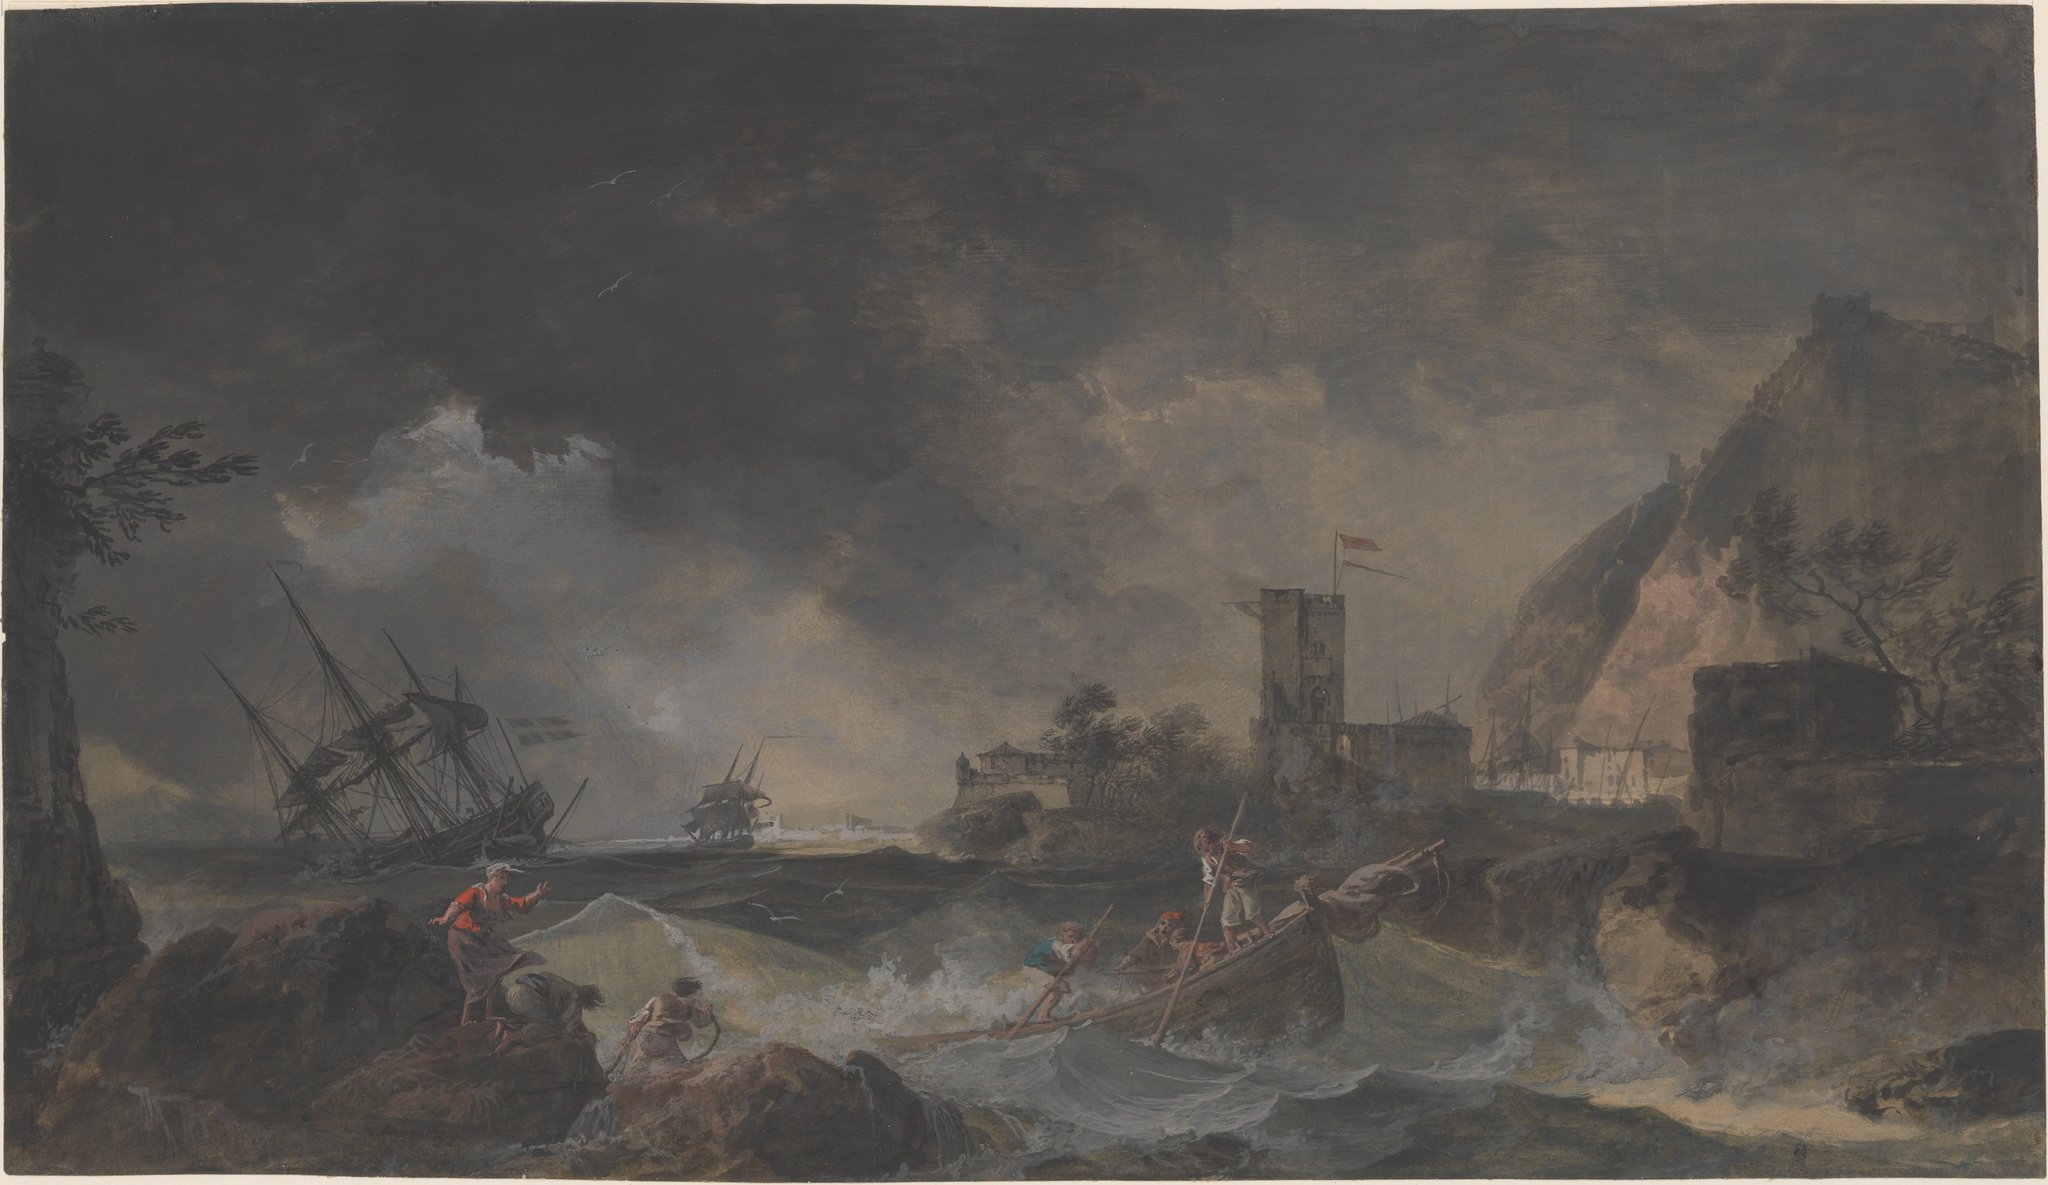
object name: drawing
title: Storm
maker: joseph vernet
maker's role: artist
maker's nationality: french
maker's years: 1714-1789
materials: gouache, paper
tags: storms,boats,ships